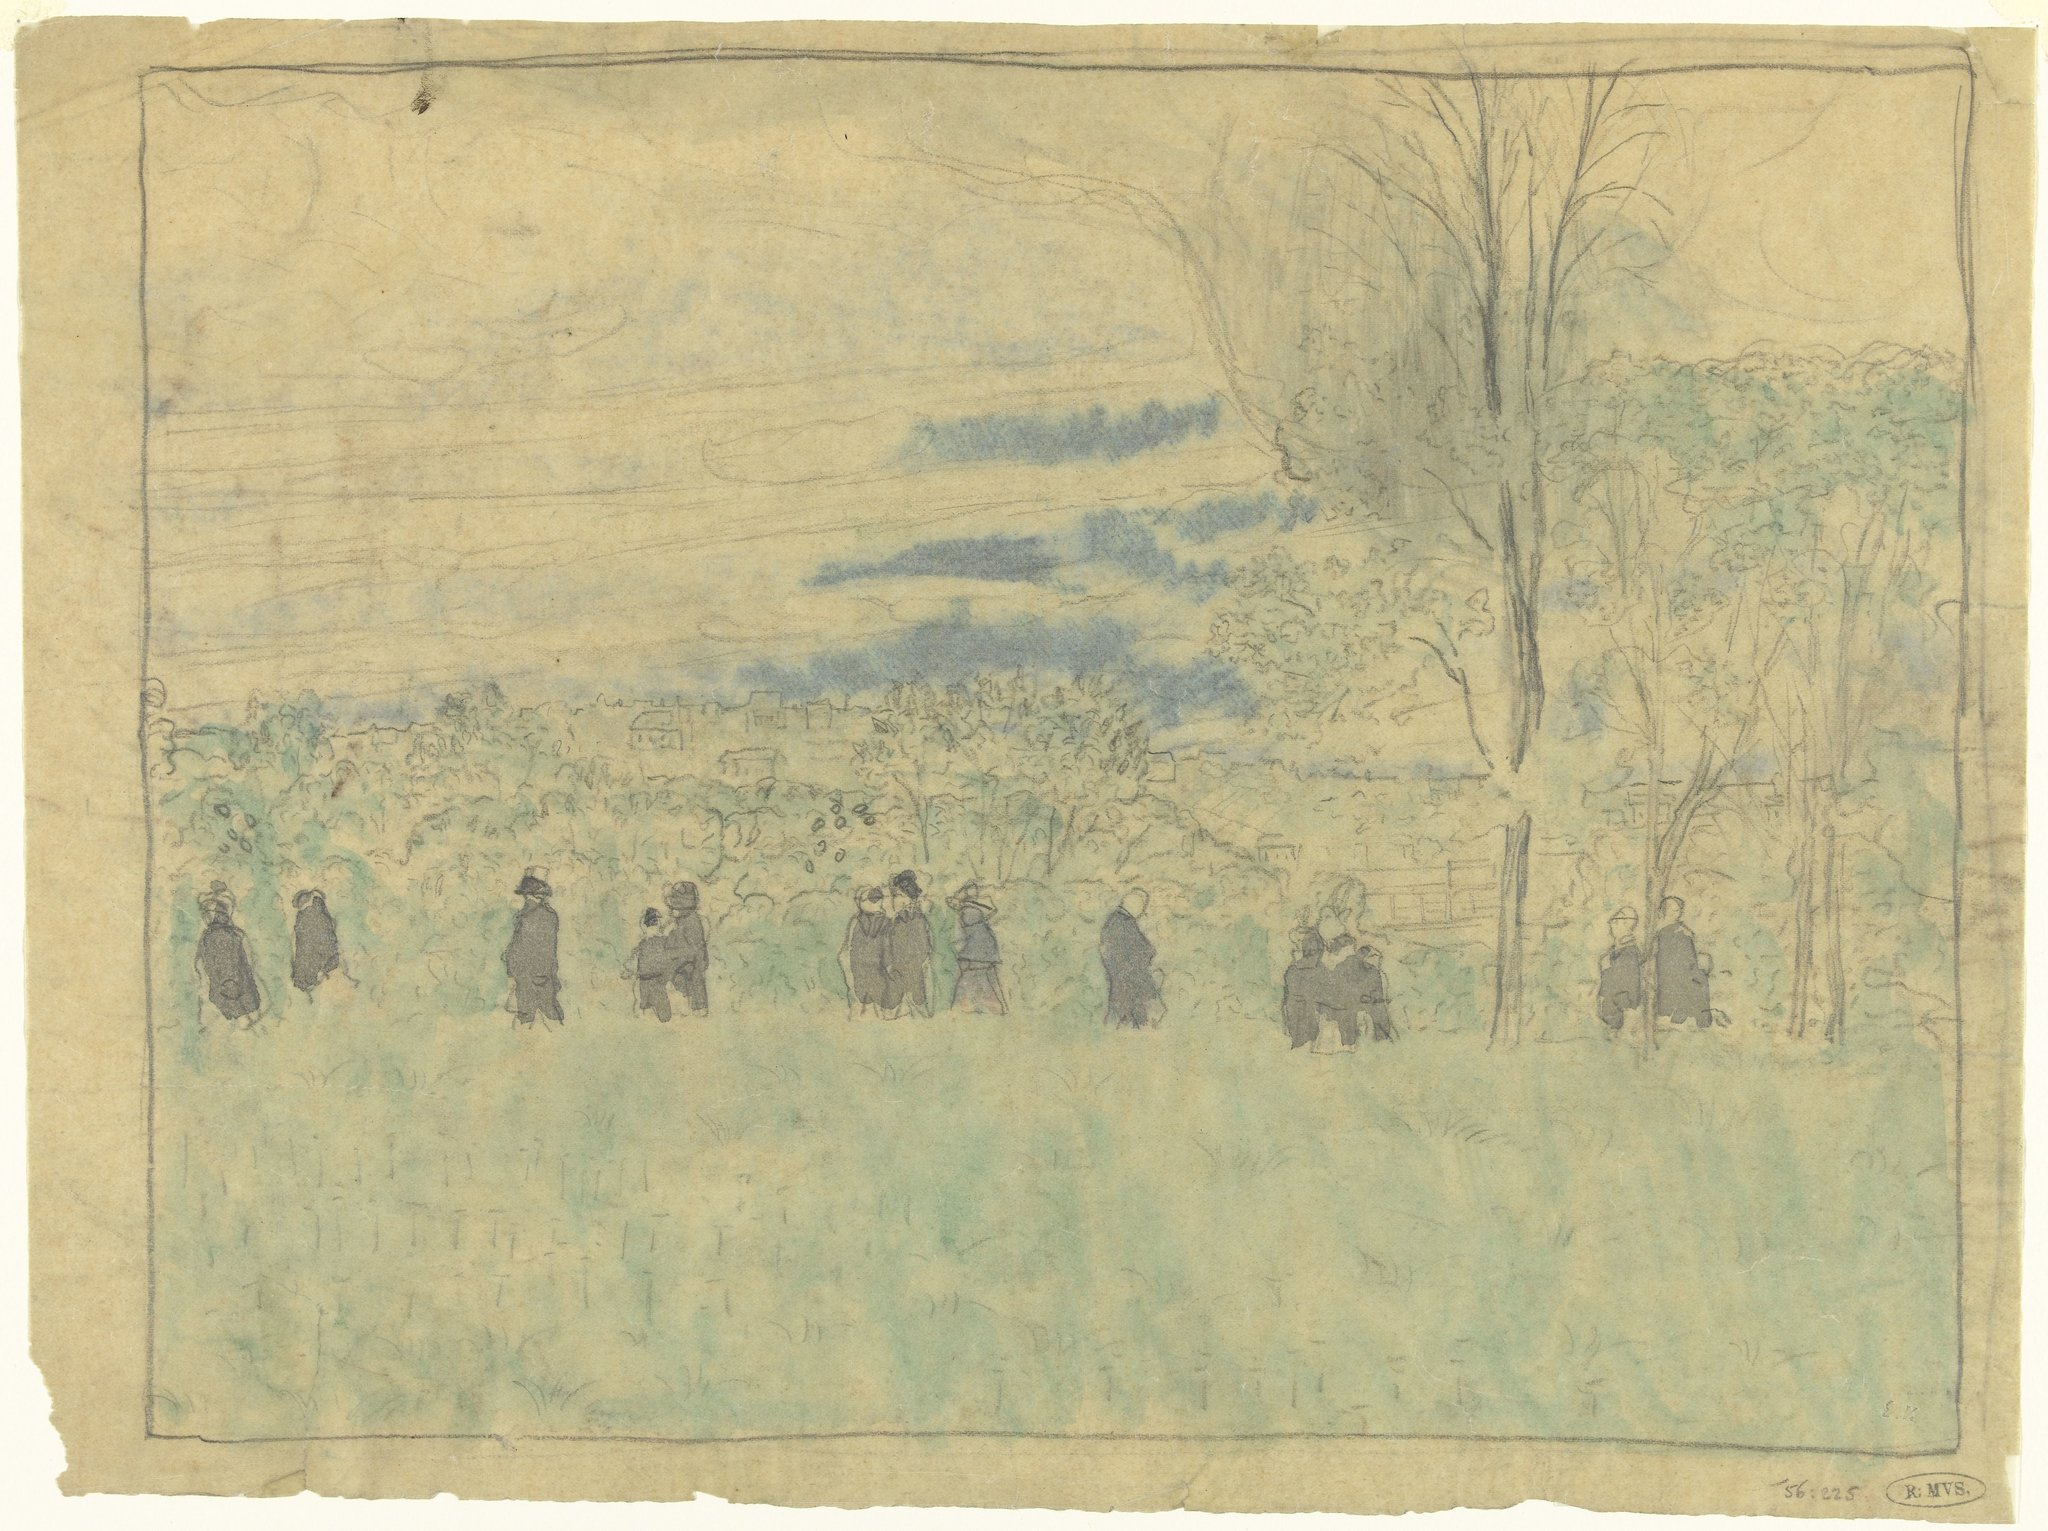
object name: drawing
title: Landschap met wandelaars: begrafenisoptocht (?)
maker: édouard vuillard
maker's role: draughtsman, print maker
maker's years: 1868-1940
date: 1878-1940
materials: chalk, paper, watercolor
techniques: brush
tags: walking, hiking (recreation), cortege, funeral procession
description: Voorstudie voor de lithografie 'A travers champs'.